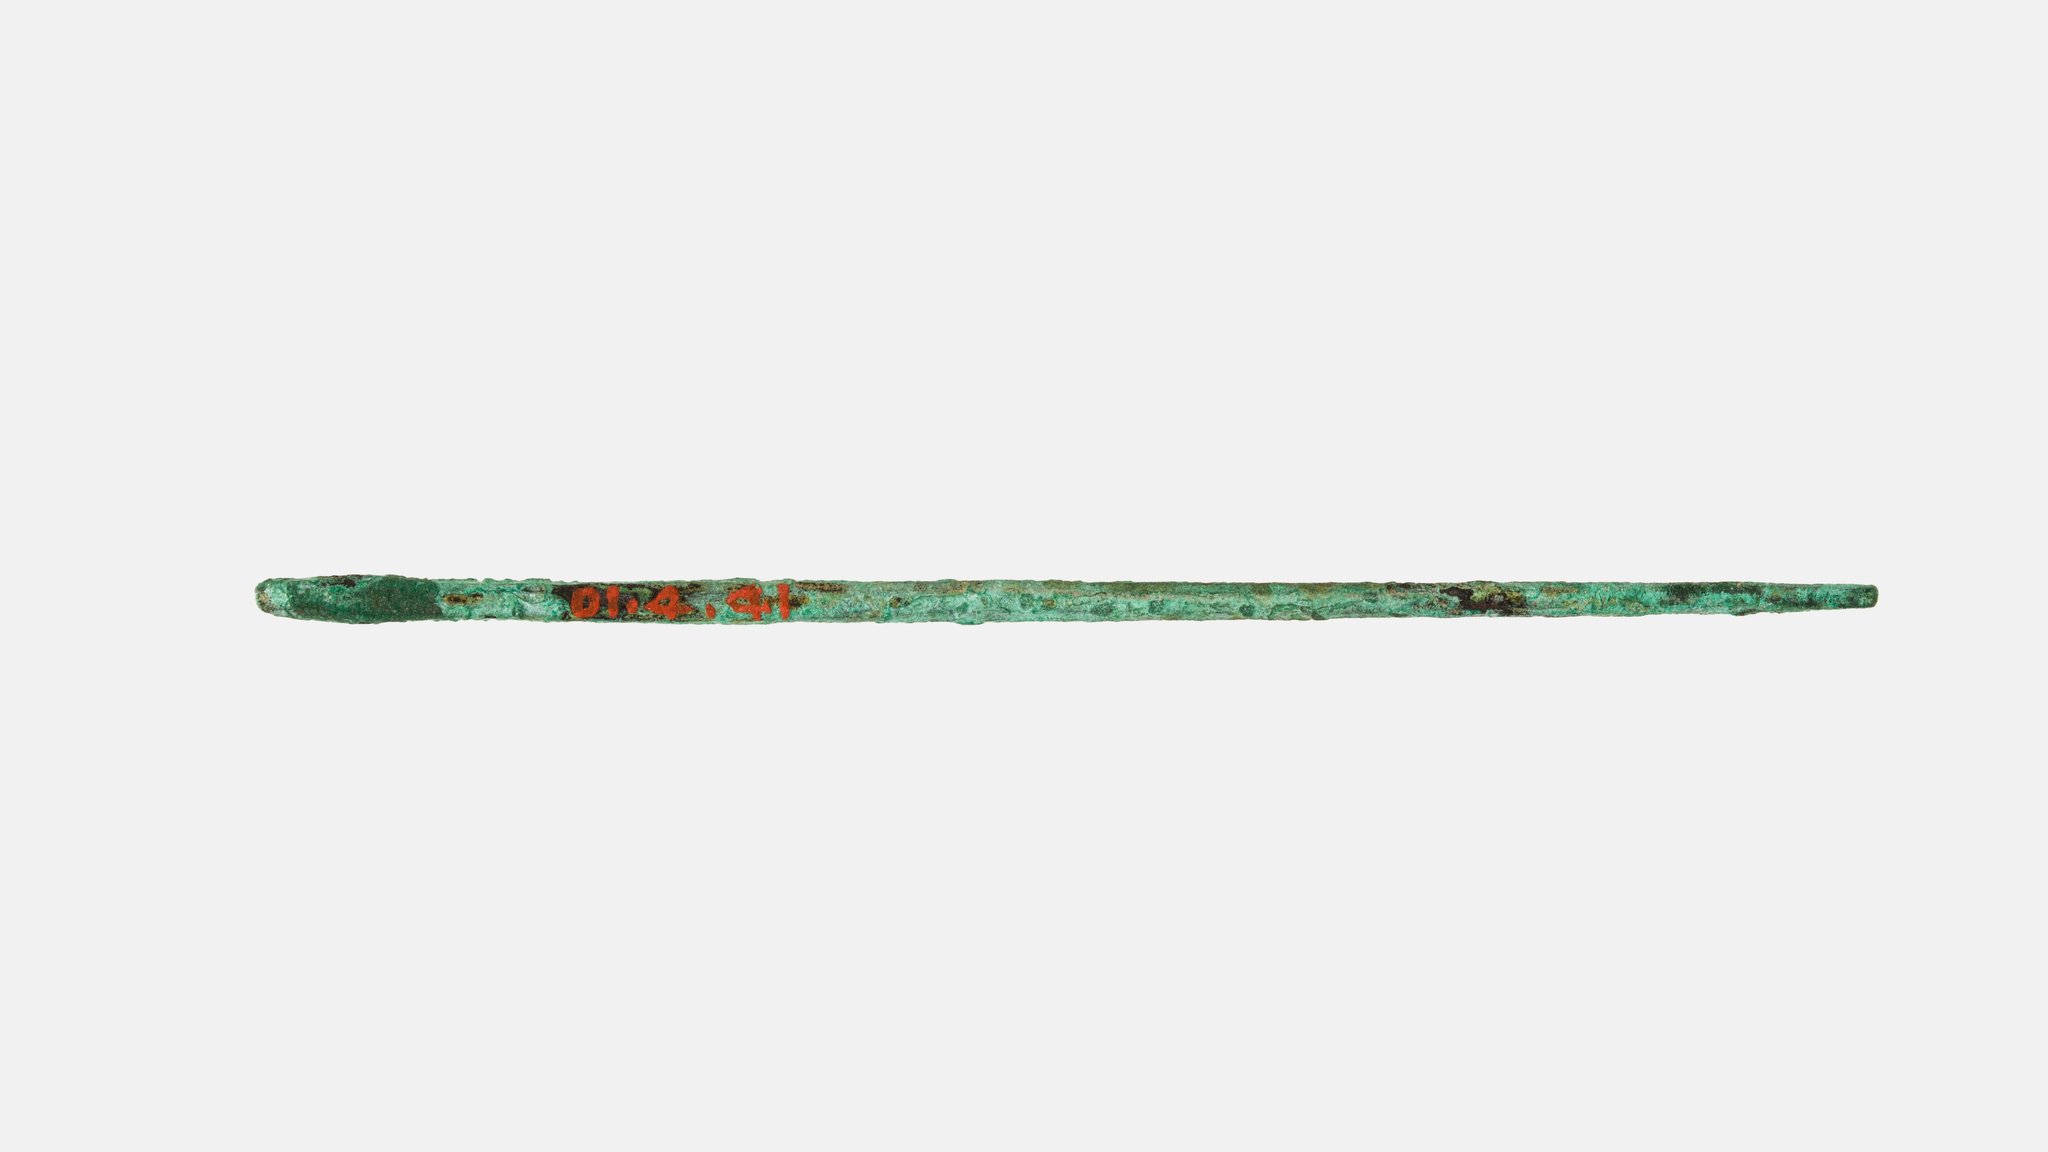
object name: cosmetic pin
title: Copper pin?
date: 2650 BCE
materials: copper alloy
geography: egypt